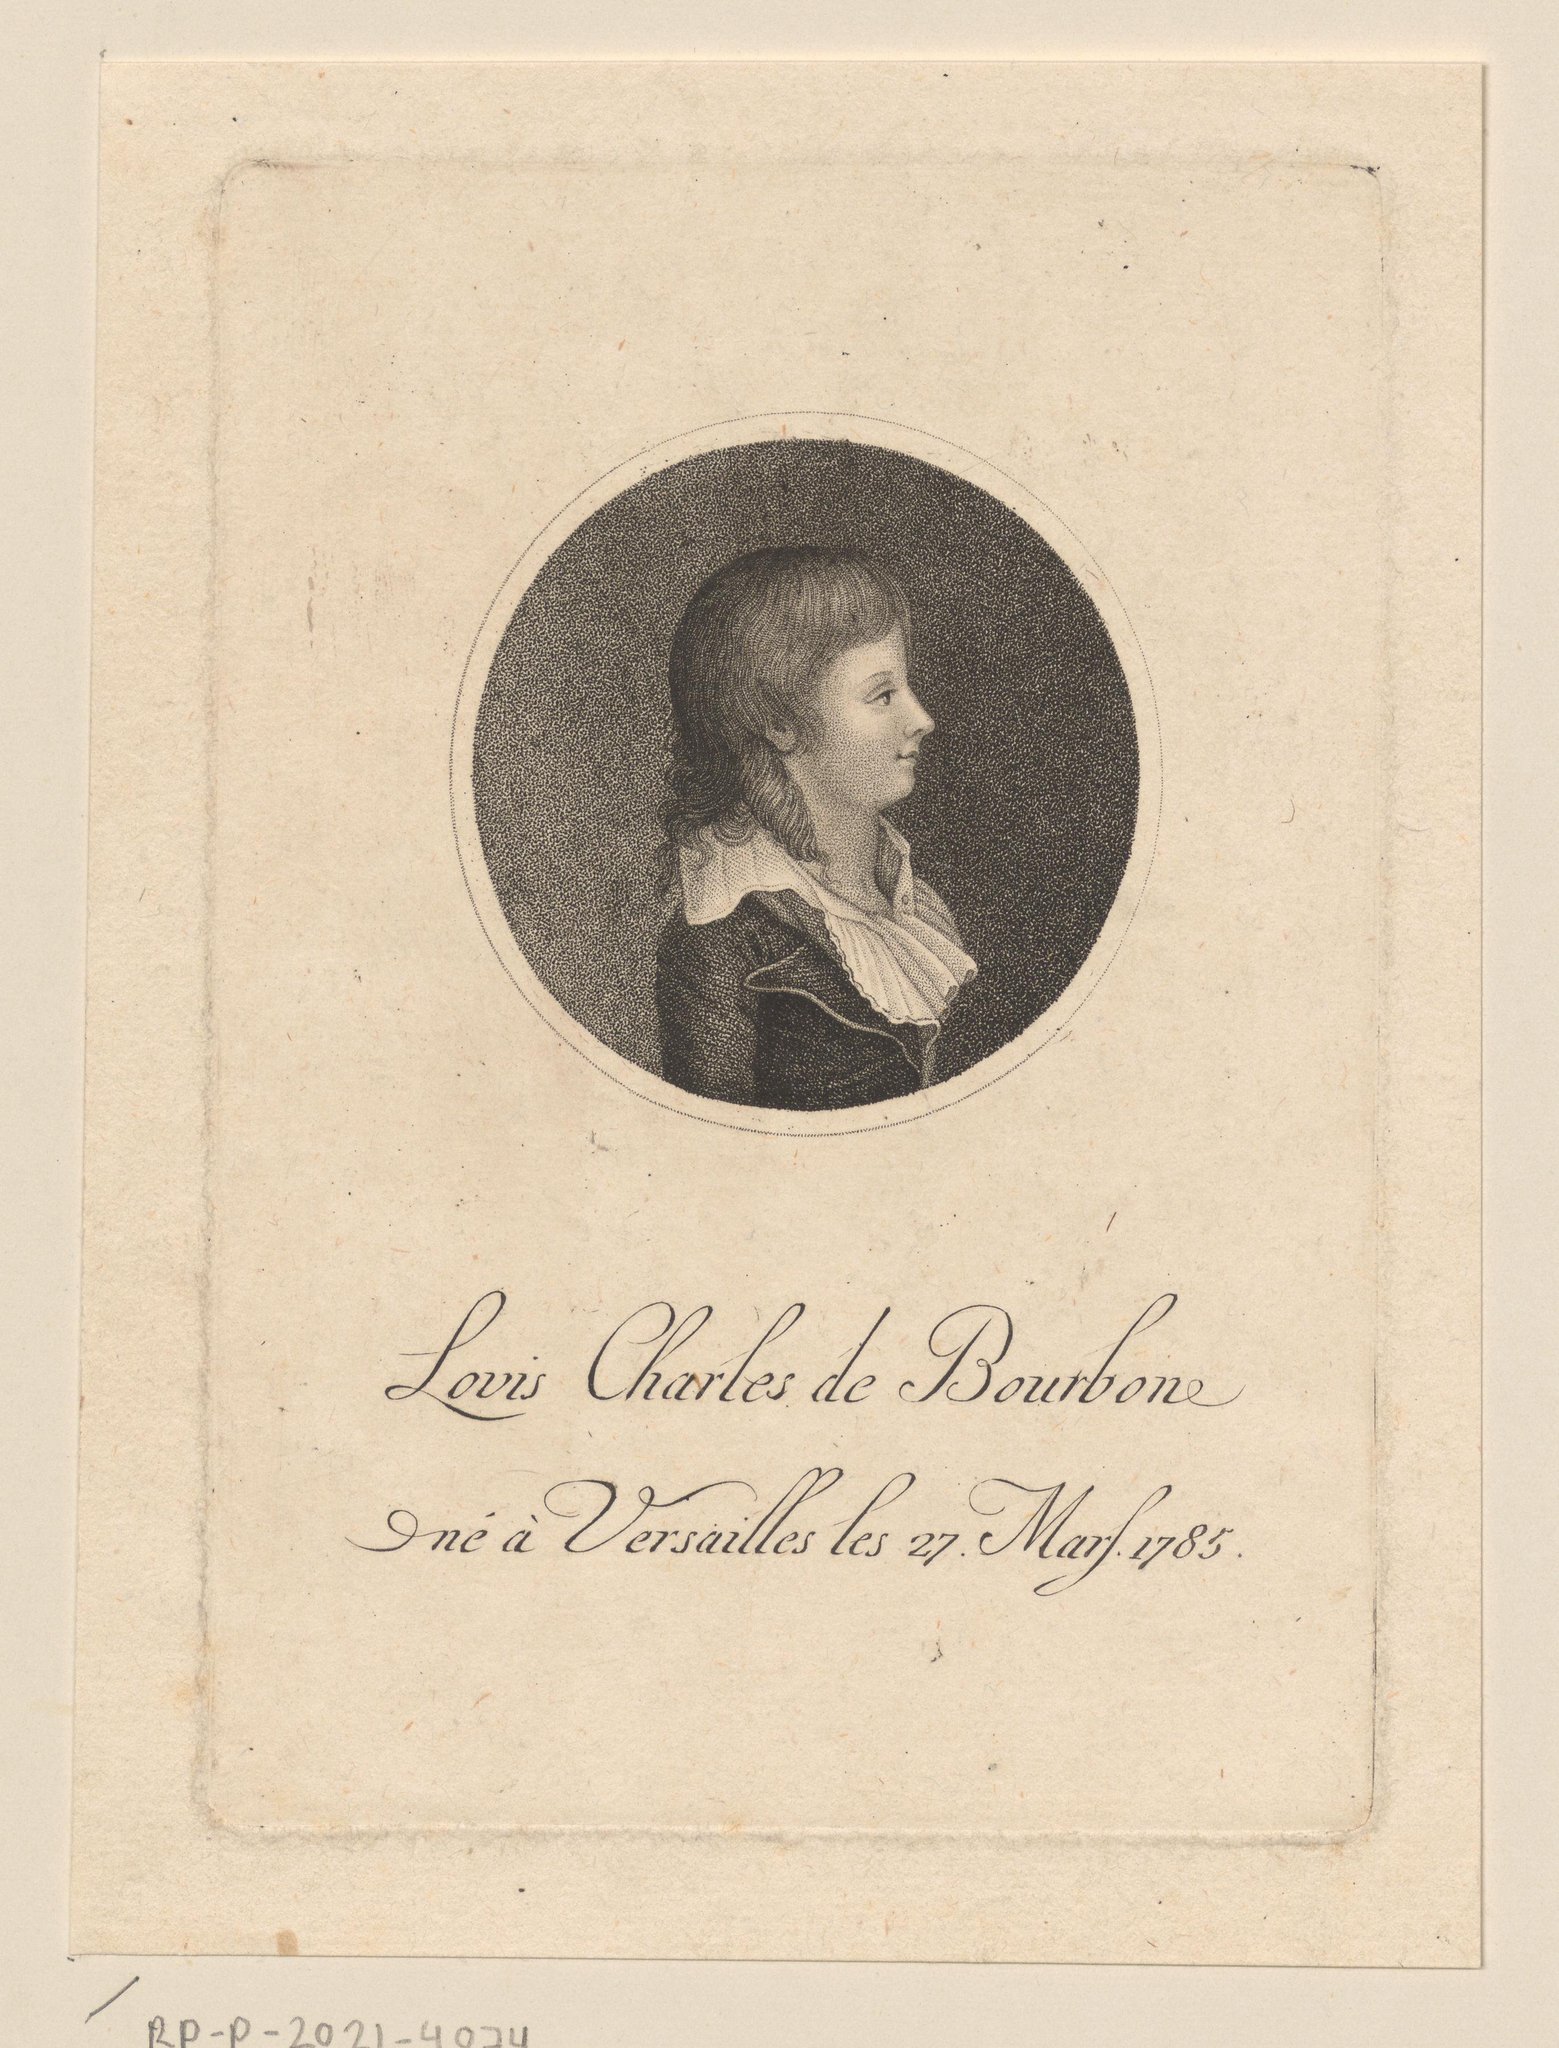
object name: print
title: Portret van Lodewijk XVII van Frankrijk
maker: Anonymous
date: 1790-1793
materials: paper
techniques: stippling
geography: france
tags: historical persons